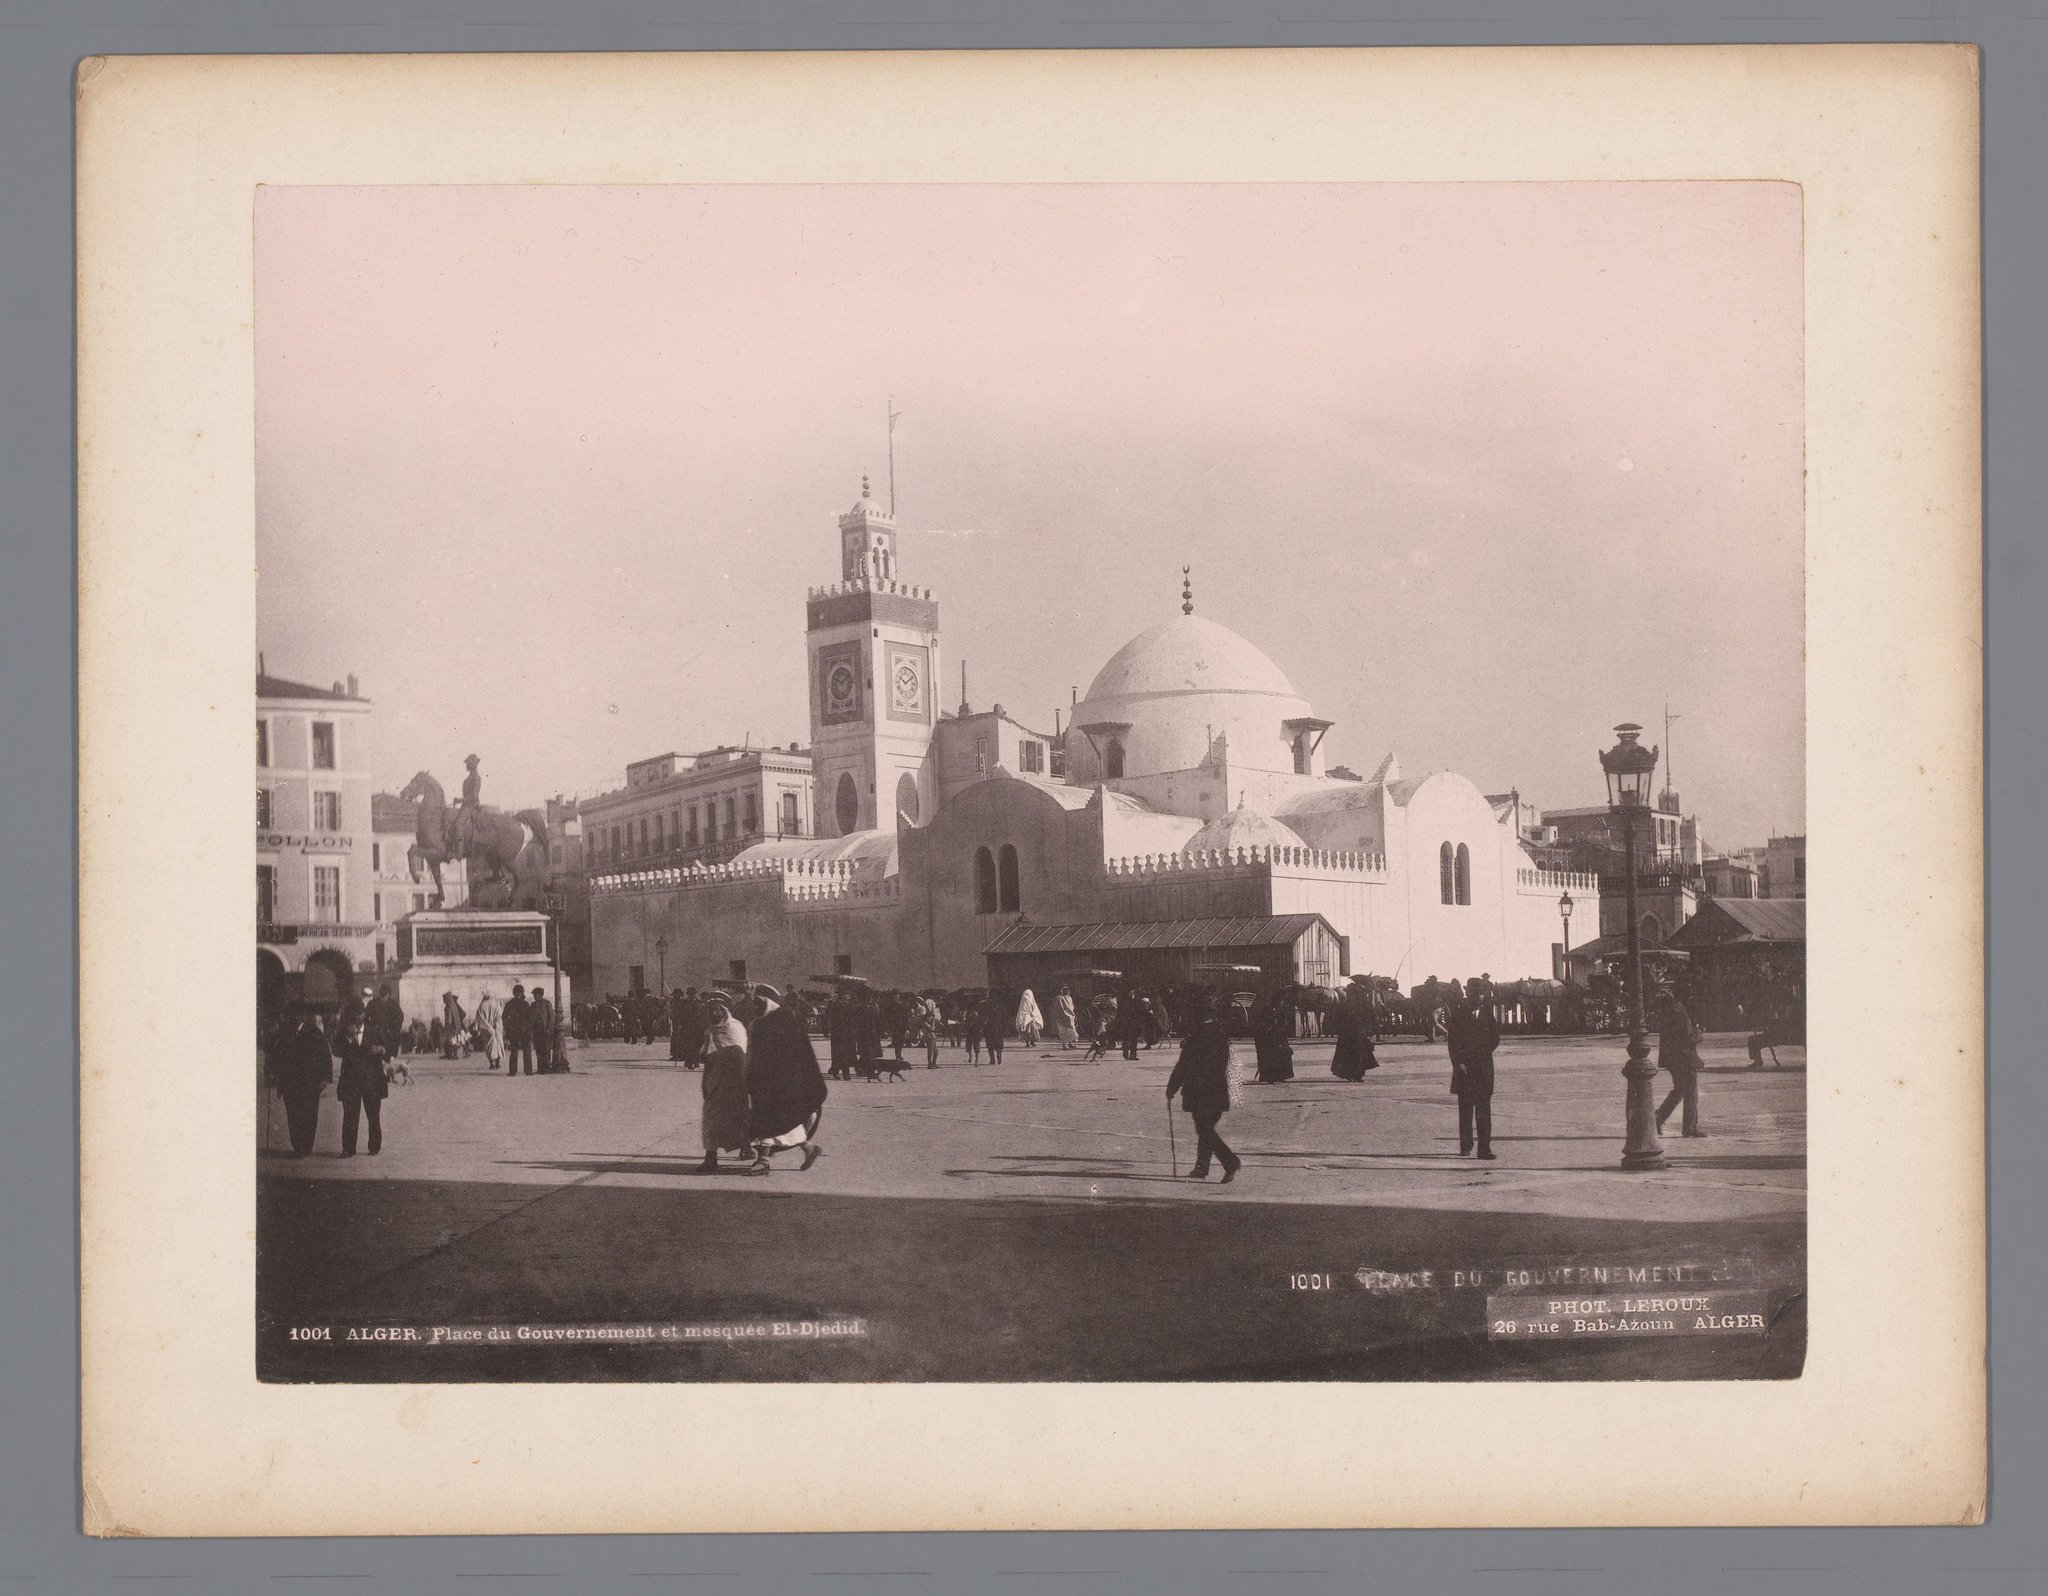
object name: photomechanical print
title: Alger, Place du Gouvernement et mosquée El-Djedid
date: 1875-1900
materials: cardboard, paper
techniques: photograph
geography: algiers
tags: temple, shrine ~ islam, mohammedanism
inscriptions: number: ‘1001’, address: ‘26 rue Bab-Azoun ALGER’